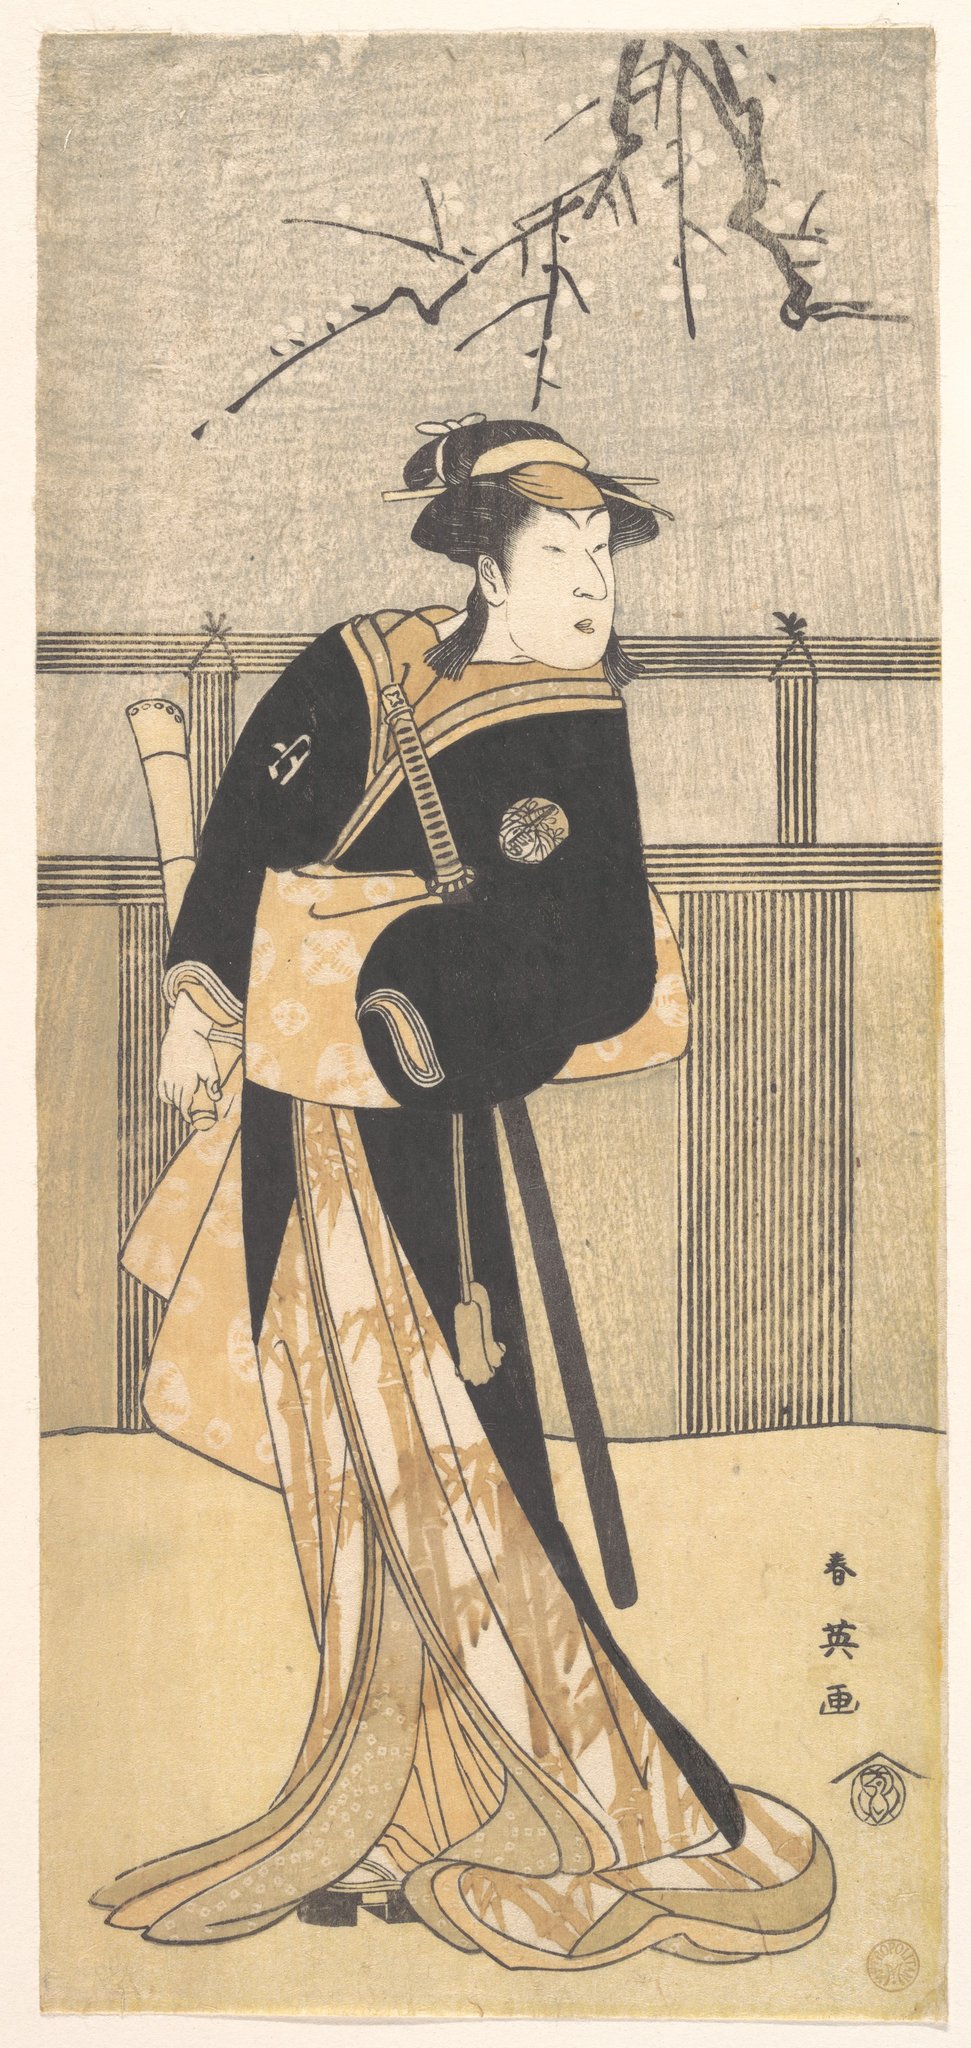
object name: print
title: Nakayama Tomisaburo in the role of An no Oyasu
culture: japanese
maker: katsukawa shun'ei 勝川春英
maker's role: artist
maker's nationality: japanese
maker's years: 1762-1819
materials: ink, paper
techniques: woodblock print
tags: swords,men,actors